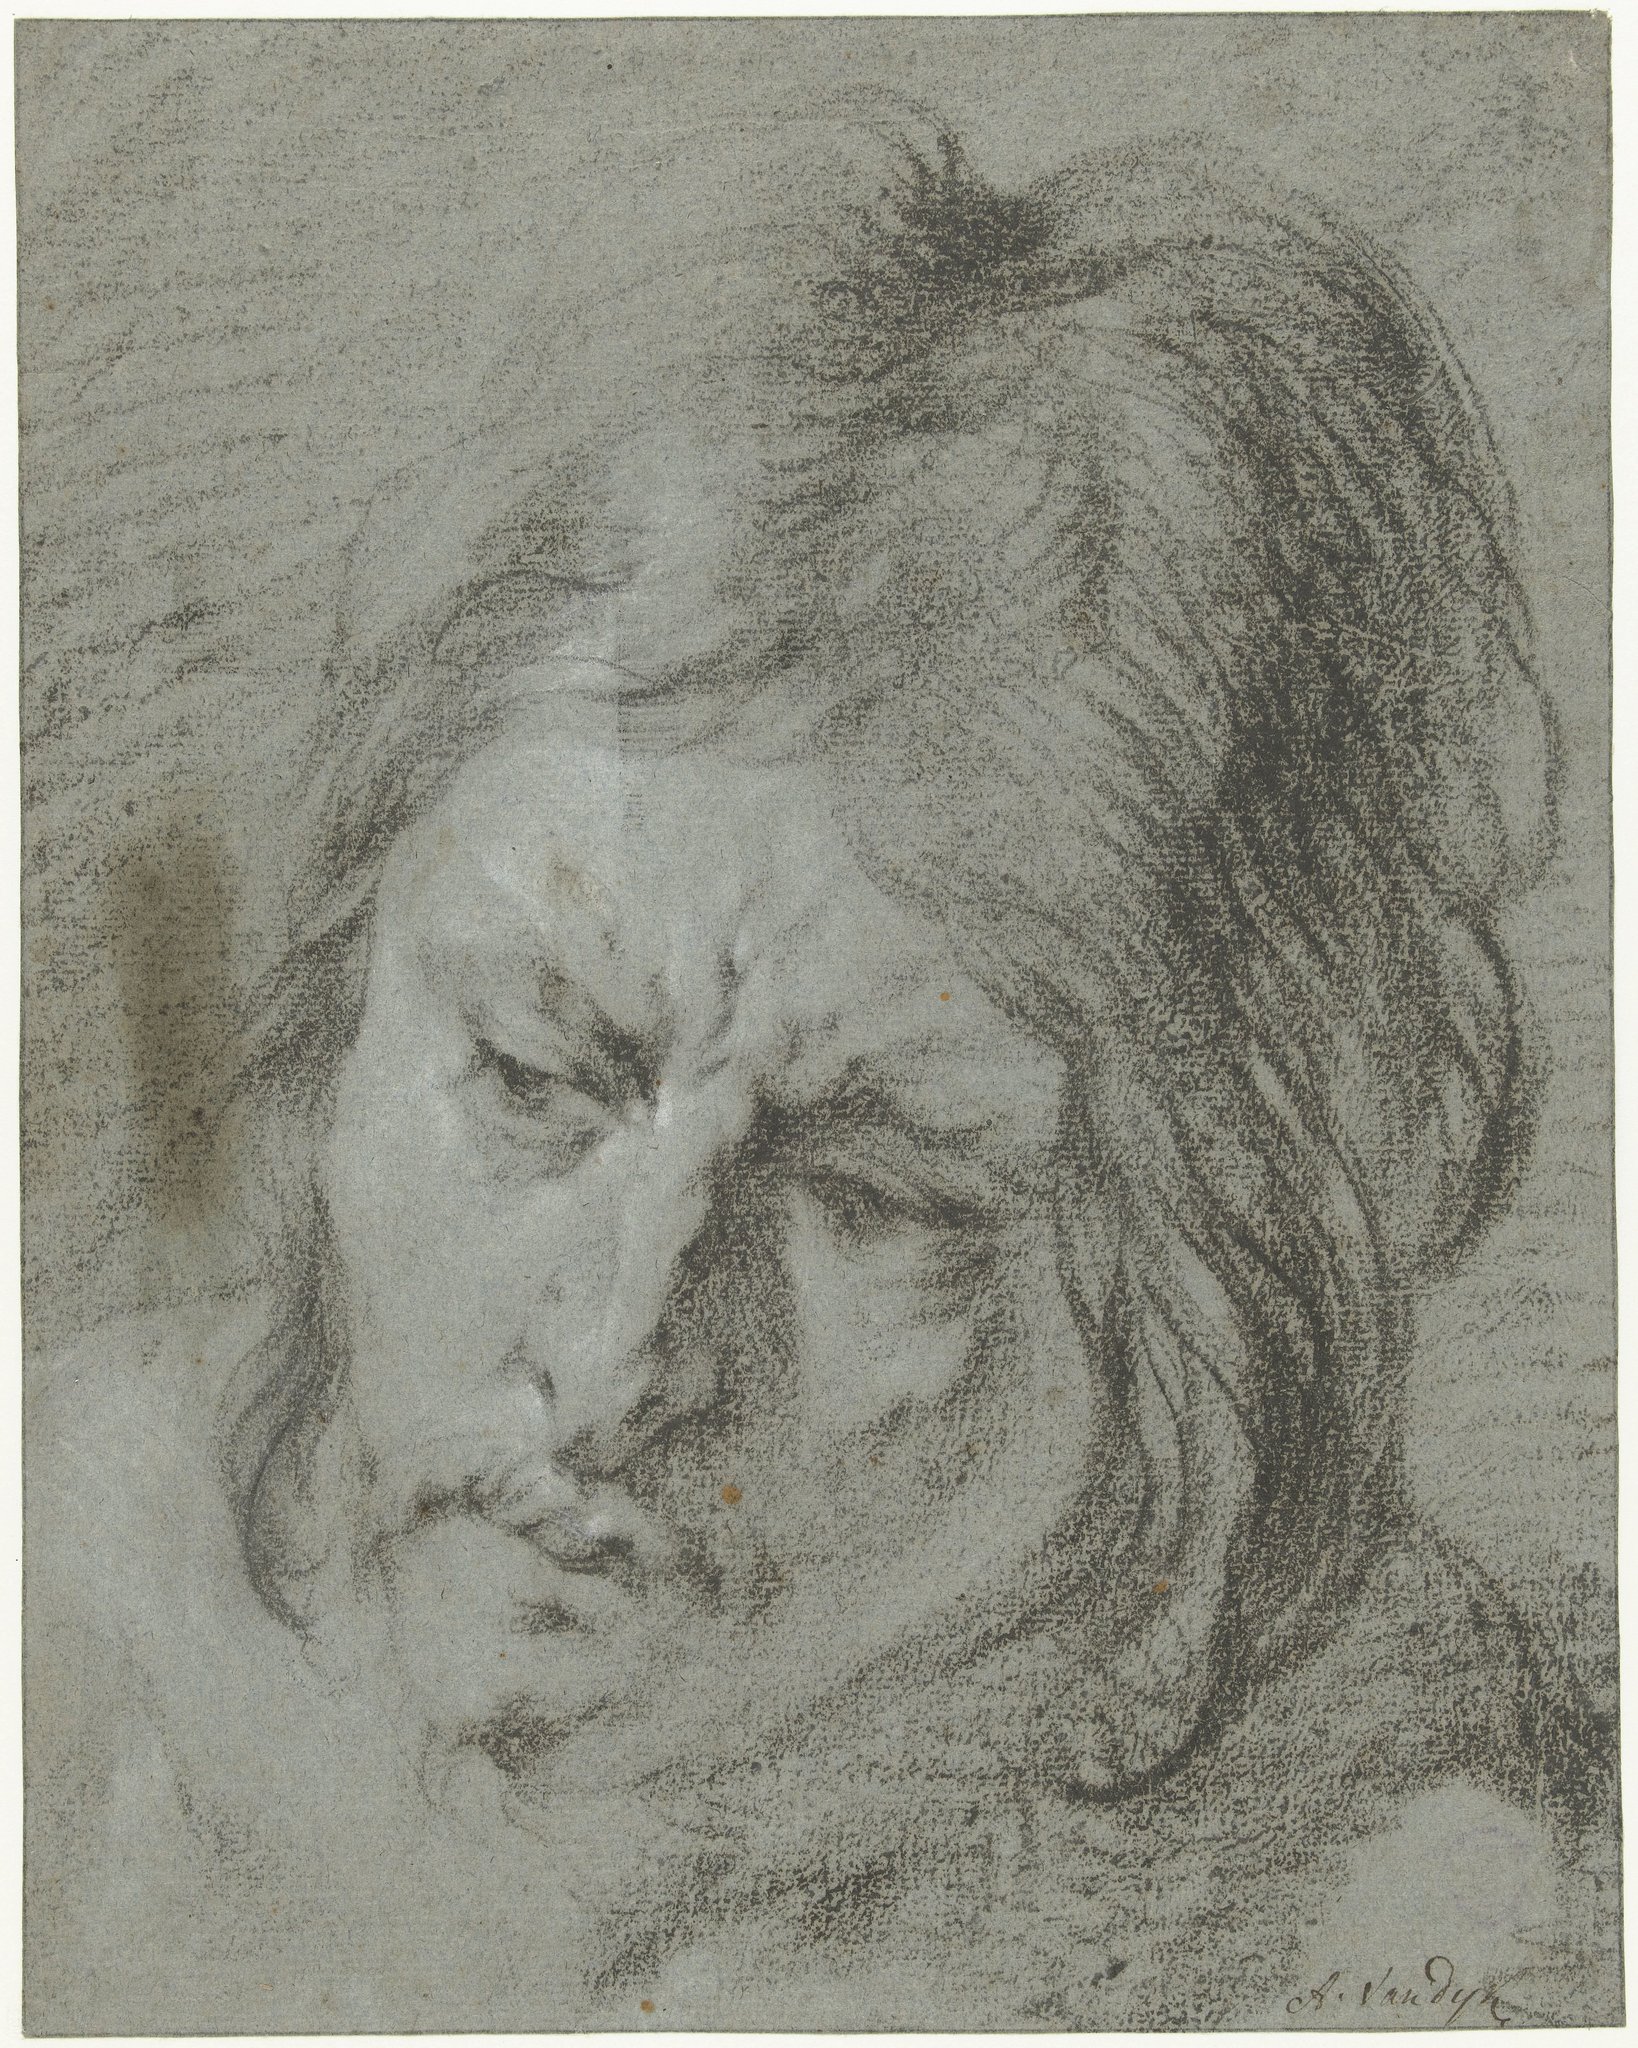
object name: drawing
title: Manskop, met lang haar, van voren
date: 1610-1641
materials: chalk, paper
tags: anonymous historical person portrayed alone